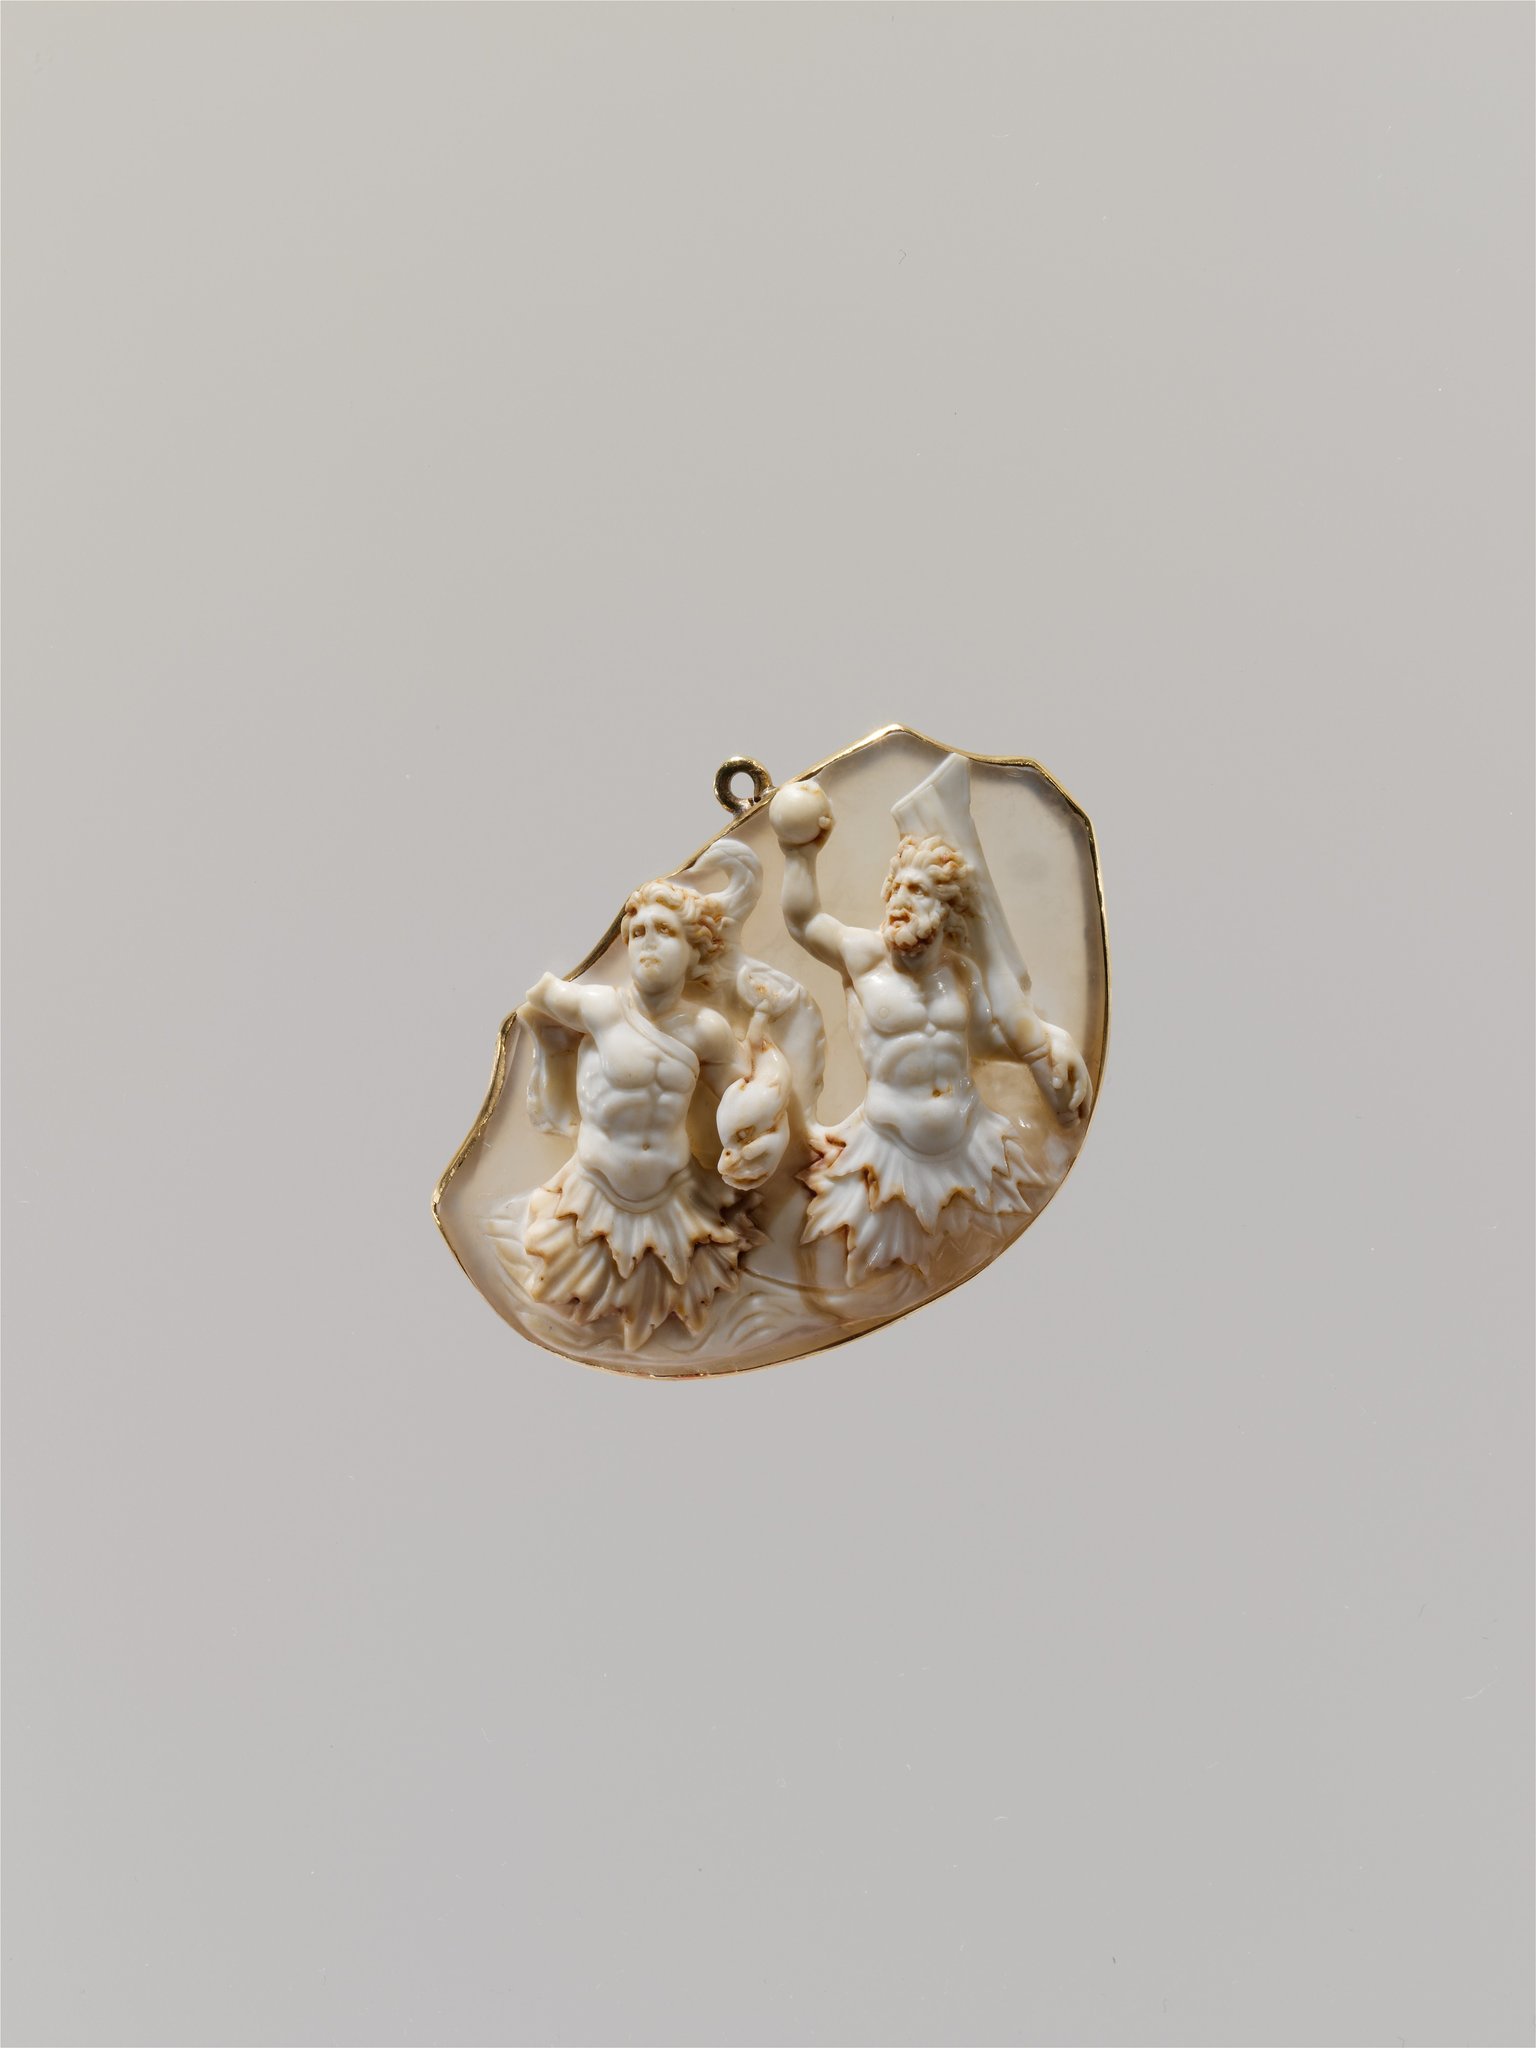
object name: cameo, fragment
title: Two Tritons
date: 1767-1800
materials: gold, onyx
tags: triton